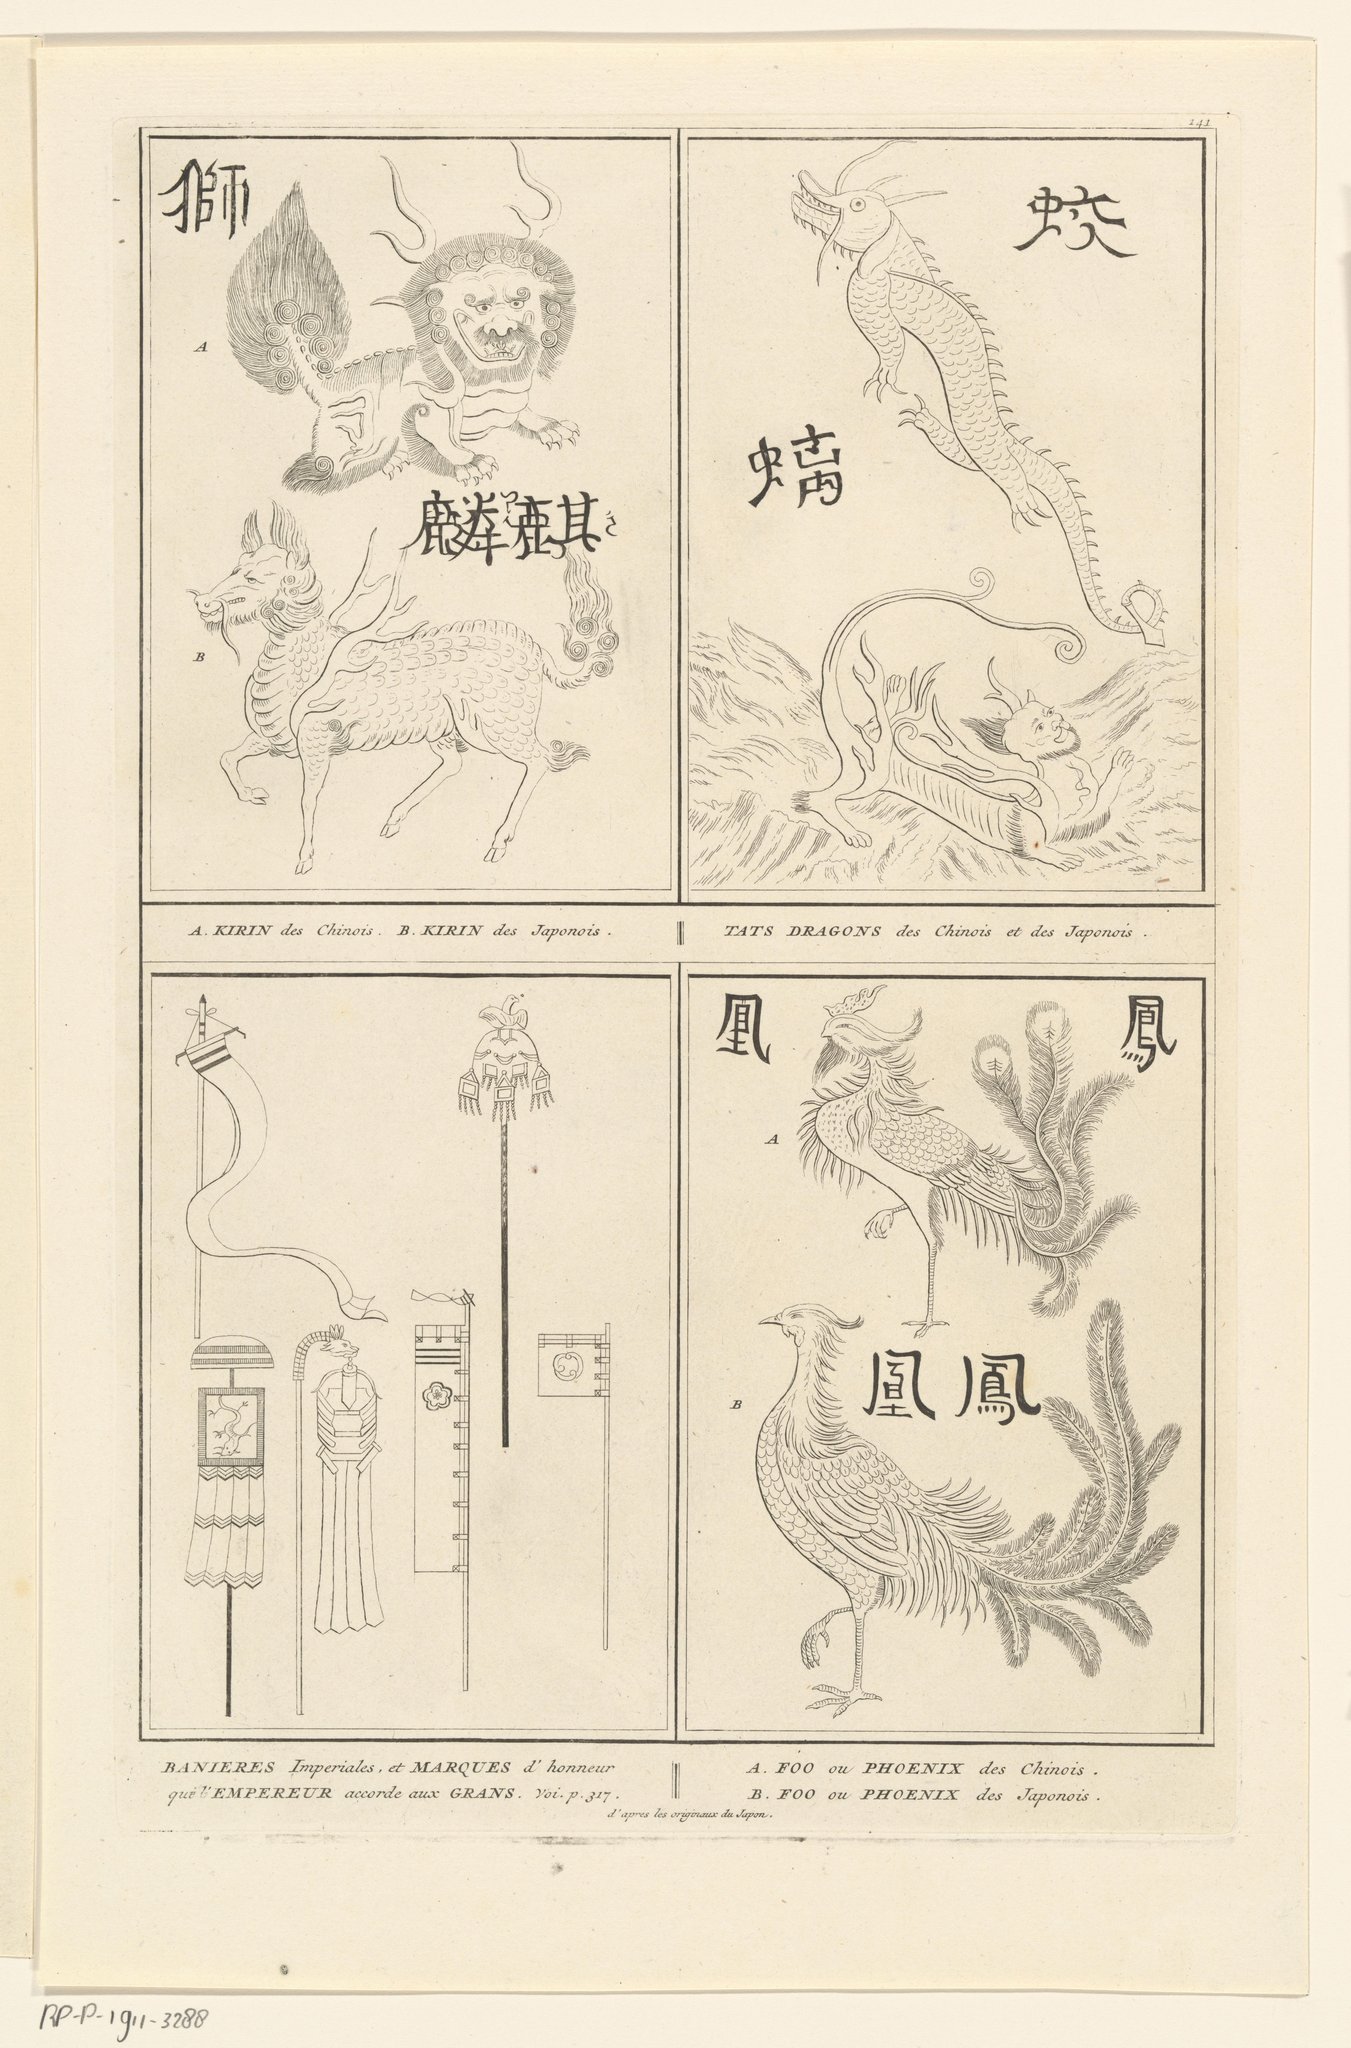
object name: book illustration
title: Animals and Attributes from Chinese and Japanese Mythology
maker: bernard picart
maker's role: draughtsman, print maker, publisher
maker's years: 1673-1733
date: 1728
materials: paper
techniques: engraving, etching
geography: amsterdam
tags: banner, standard (as symbol of the state, etc.), dragon, fabulous animals ~ birds: phoenix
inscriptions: collector's mark: Lugt 2228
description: Here Picart illustrated Chinese and Japanese versions of traditional mythological creatures from Central and East Asian cultures. Among them are lions, dragons, and phoenixes, as well as a Qilin. These mythical animals held imperial and religious significance and were considered sacred. Such illustrations bear witness to the Eurocentric perspective, demonstrating how Amsterdam book printers attempted to capture a culture unknown to them.